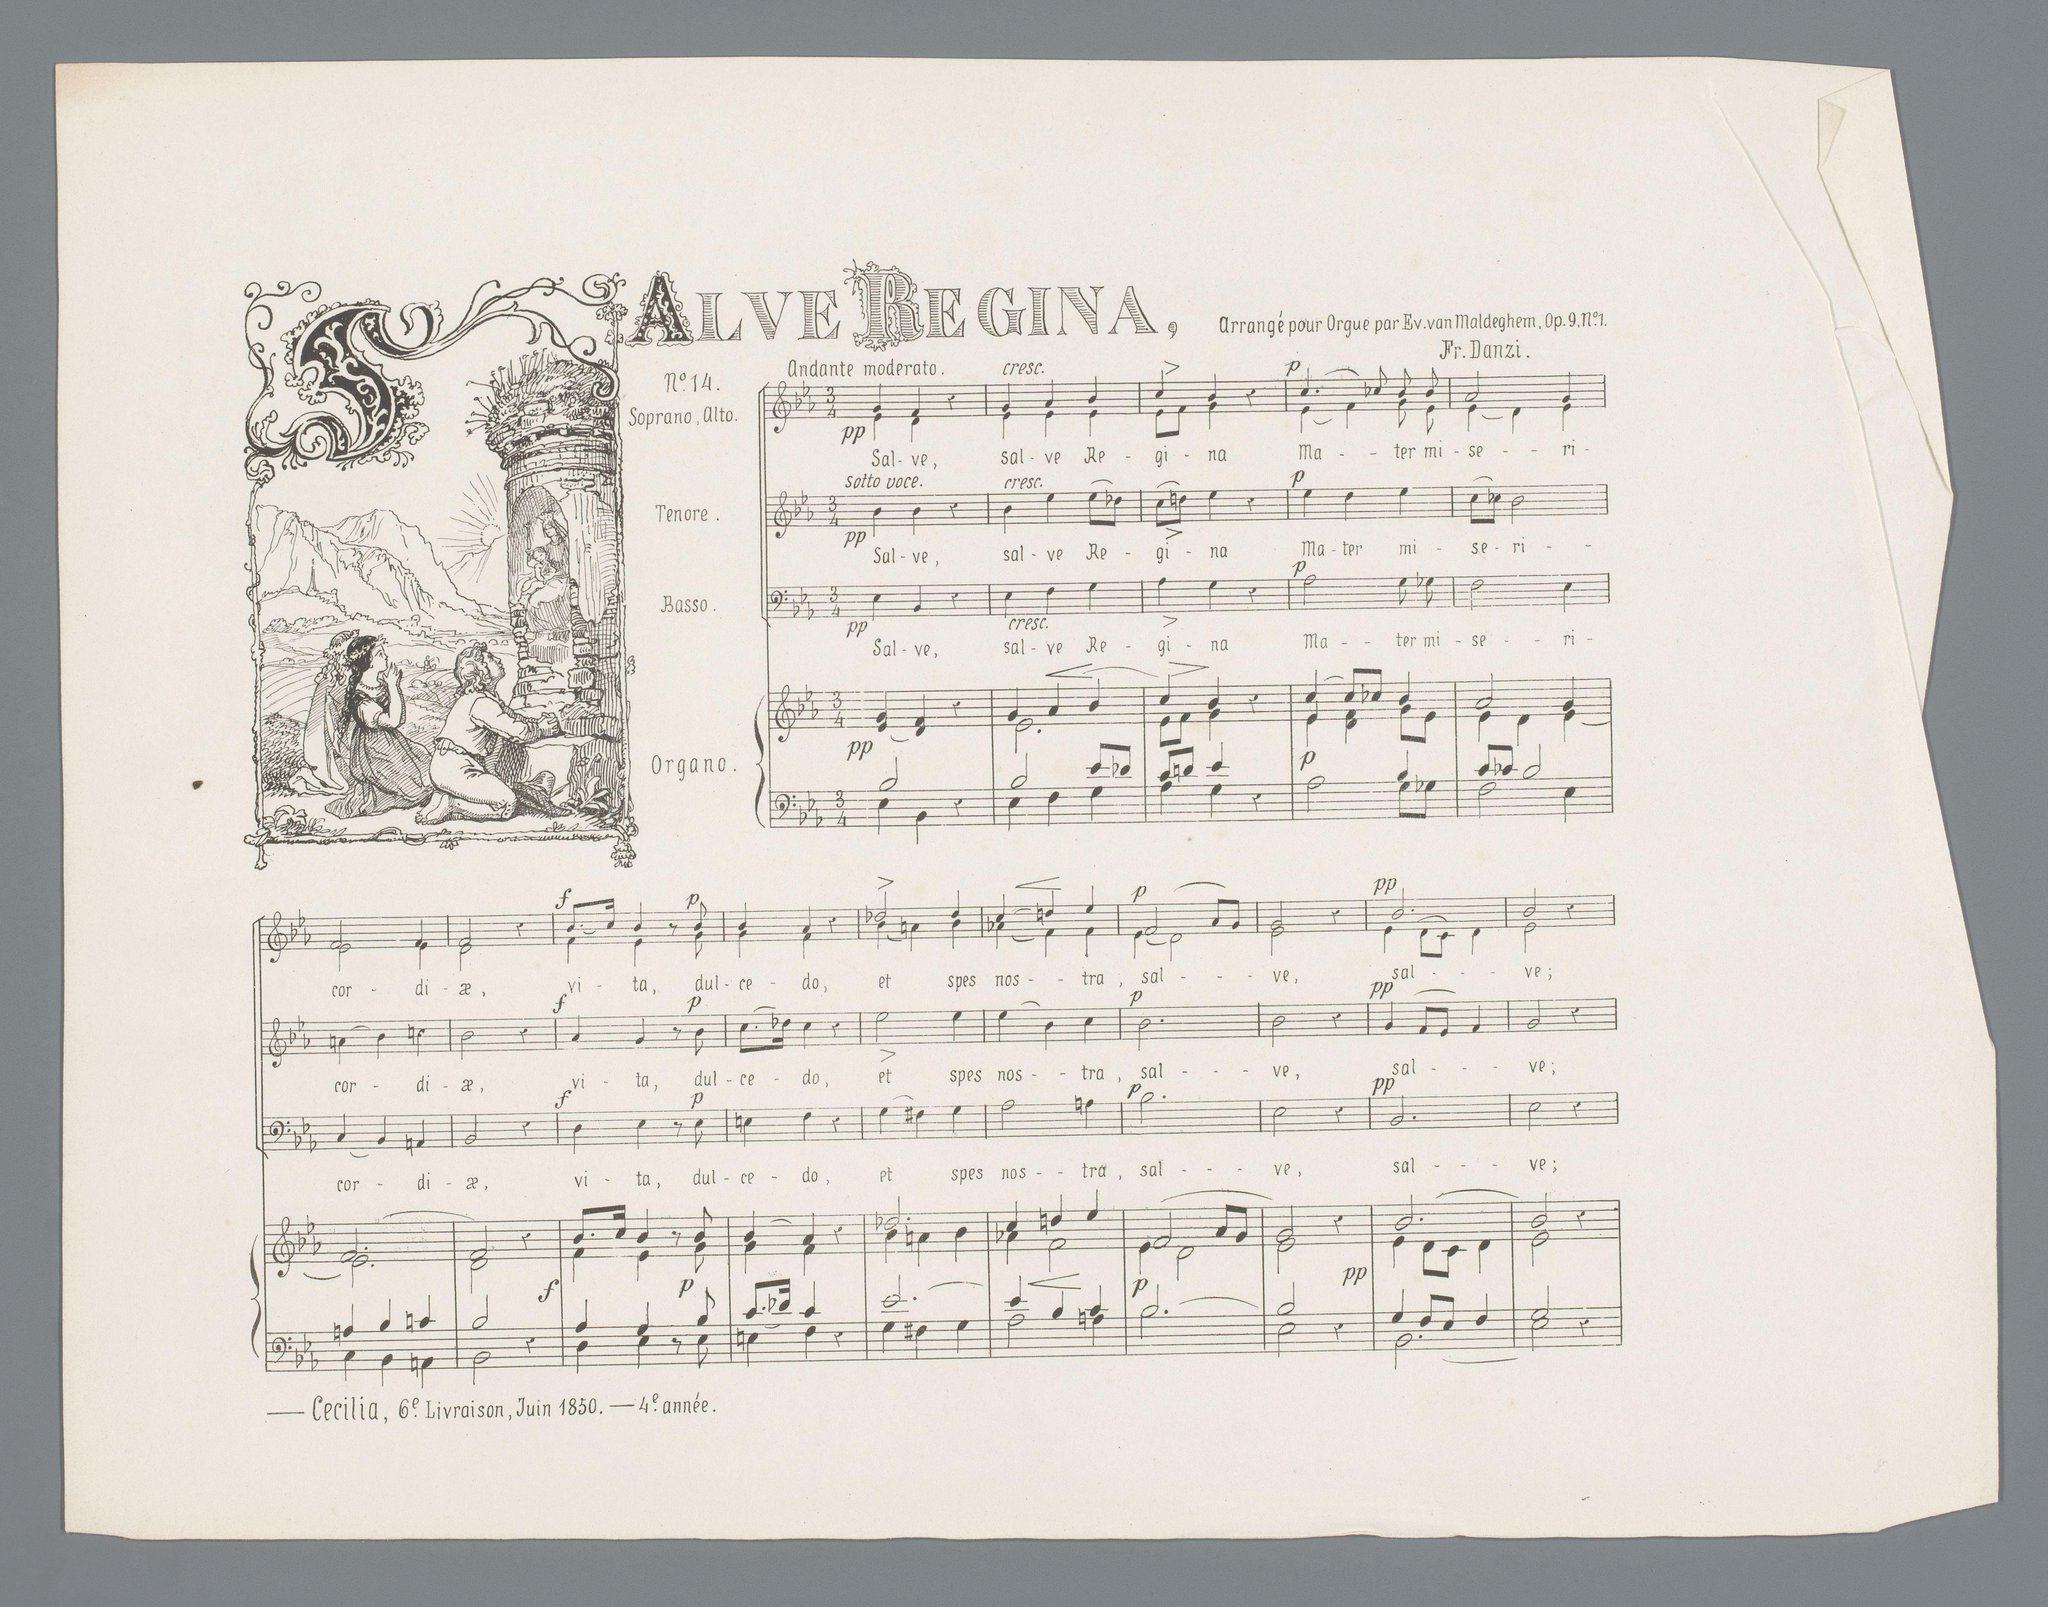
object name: muziekblad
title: Salve Regina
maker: eugène van maldeghem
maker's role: draughtsman, painter, print maker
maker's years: 1813-1867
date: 1850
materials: paper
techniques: lithograph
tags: notation of music, (public) prayer, altar, mountains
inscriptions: collector's mark: Lugt 2228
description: Prent uit: Cecilia, journal mensuel de musique d'église 4 (1850), nr. 6.